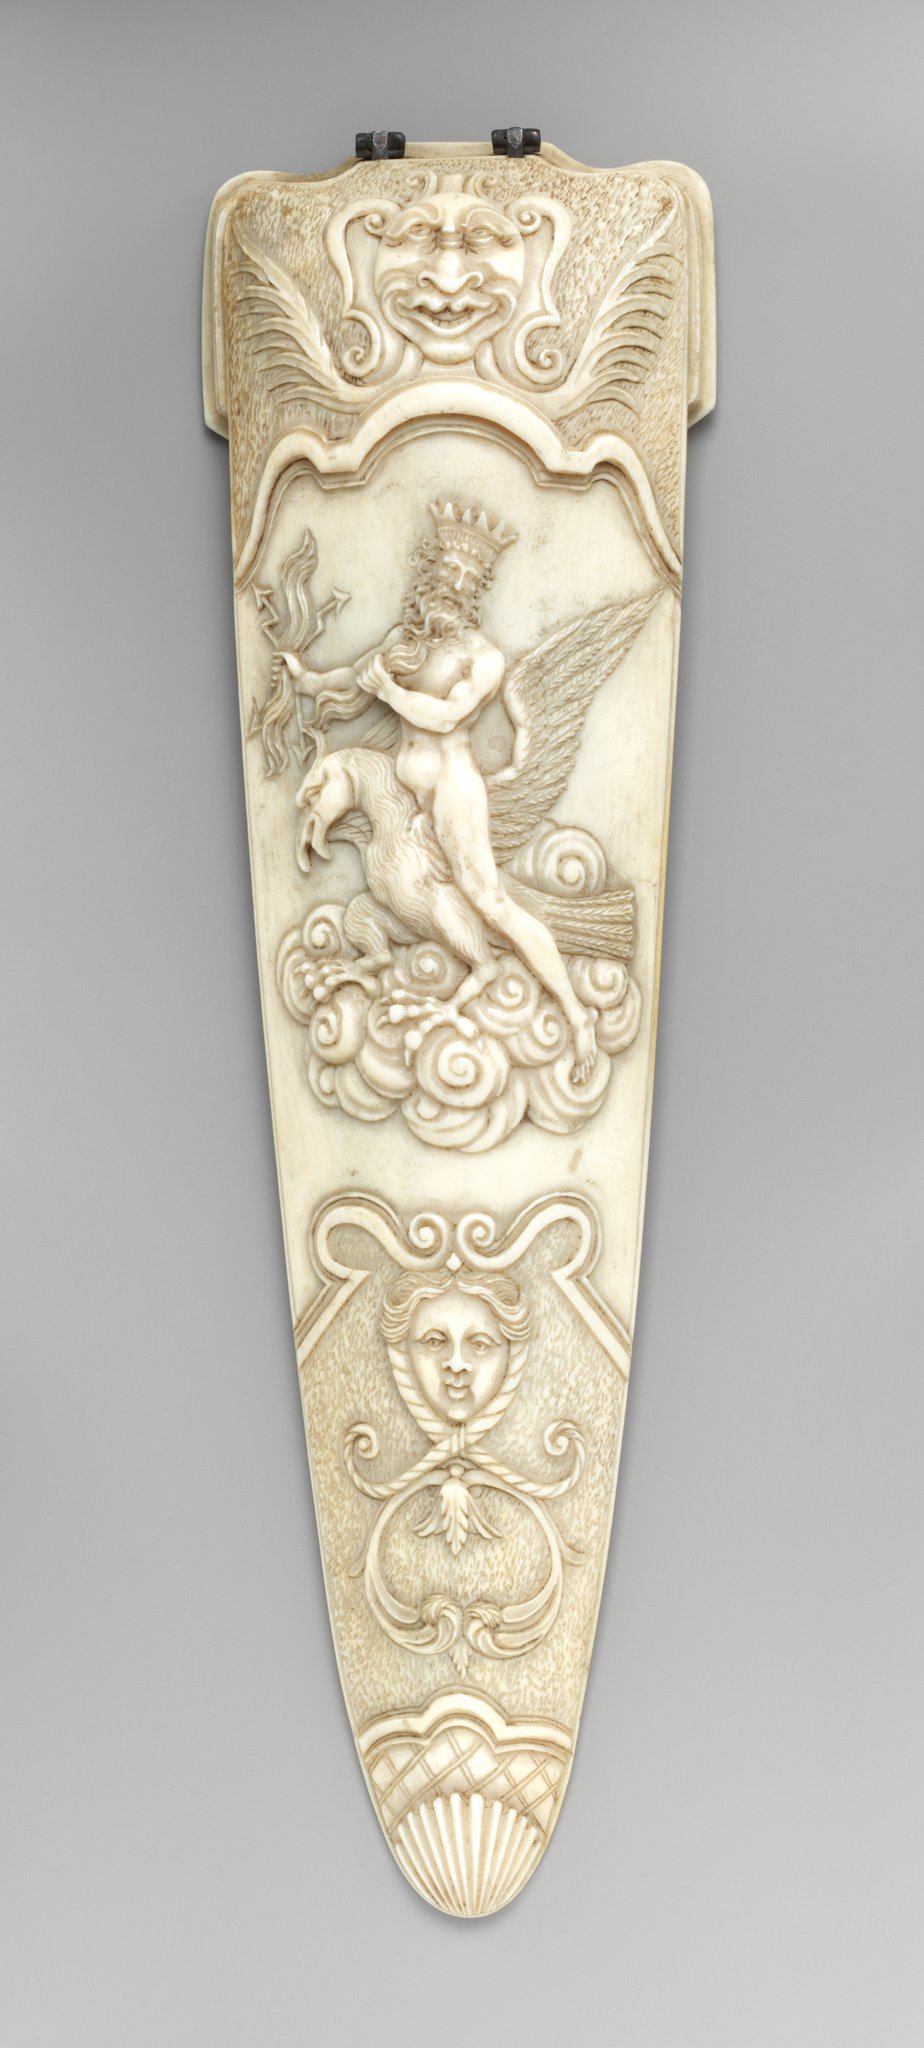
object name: tobacco rasp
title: Tobacco rasp carved with Zeus astride an eagle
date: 1667-1733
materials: iron, ivory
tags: eagles,male nudes,zeus